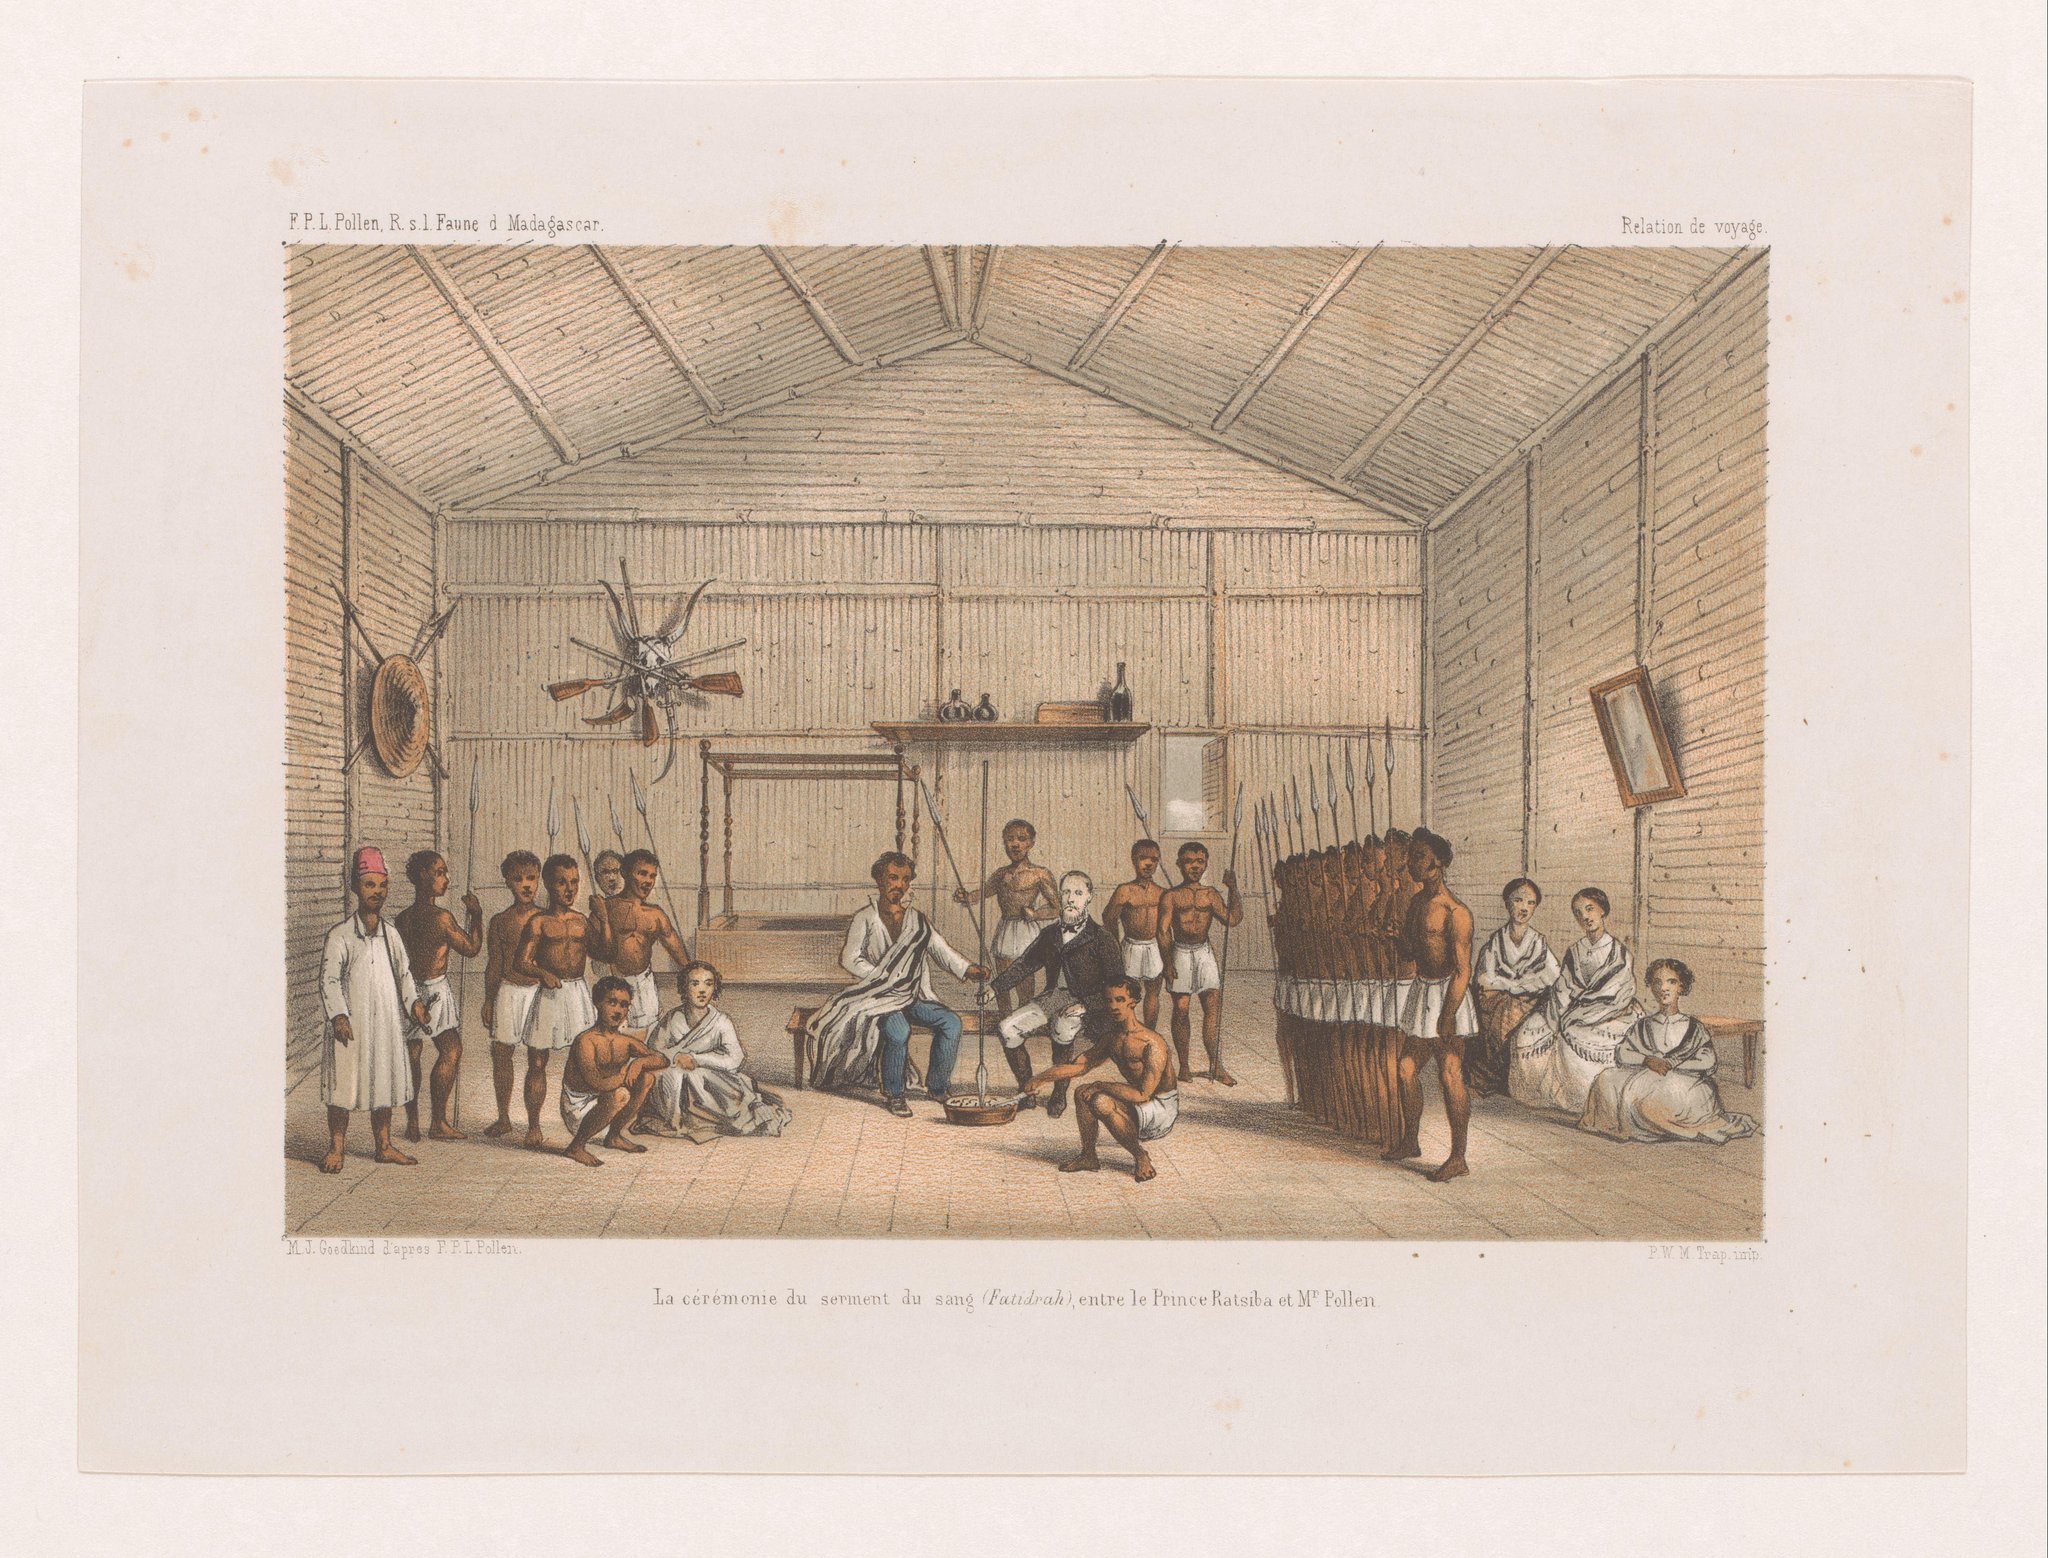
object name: book illustration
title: La cérémonie du serment du sang (Fatidrah), entre le Prince Ratsiba et Mr. Pollen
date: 1868-1877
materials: paper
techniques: hand coloring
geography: amsterdam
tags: françois p.l. pollen, ritual practices ~ non-christian religions, casting weapons: spear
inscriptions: collector's mark: Lugt 2228, collector's mark: Lugt 2760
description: François P.L. Pollen reisde tussen 1863 en 1866 naar Madagascar. Hij verzamelde insecten, vogels, vissen en zoogdieren voor het Rijksmuseum van Natuurlijke Historie in Leiden en deed onderzoek. Deze prent maakte deel uit van: Pollen, F. P. L. Recherches sur la faune de Madagascar et de ses dépendances, d'après les découvertes de François P. L. Pollen et D. C. Van Dam. Leiden: J. K. Steenhoff, 1868-1877.